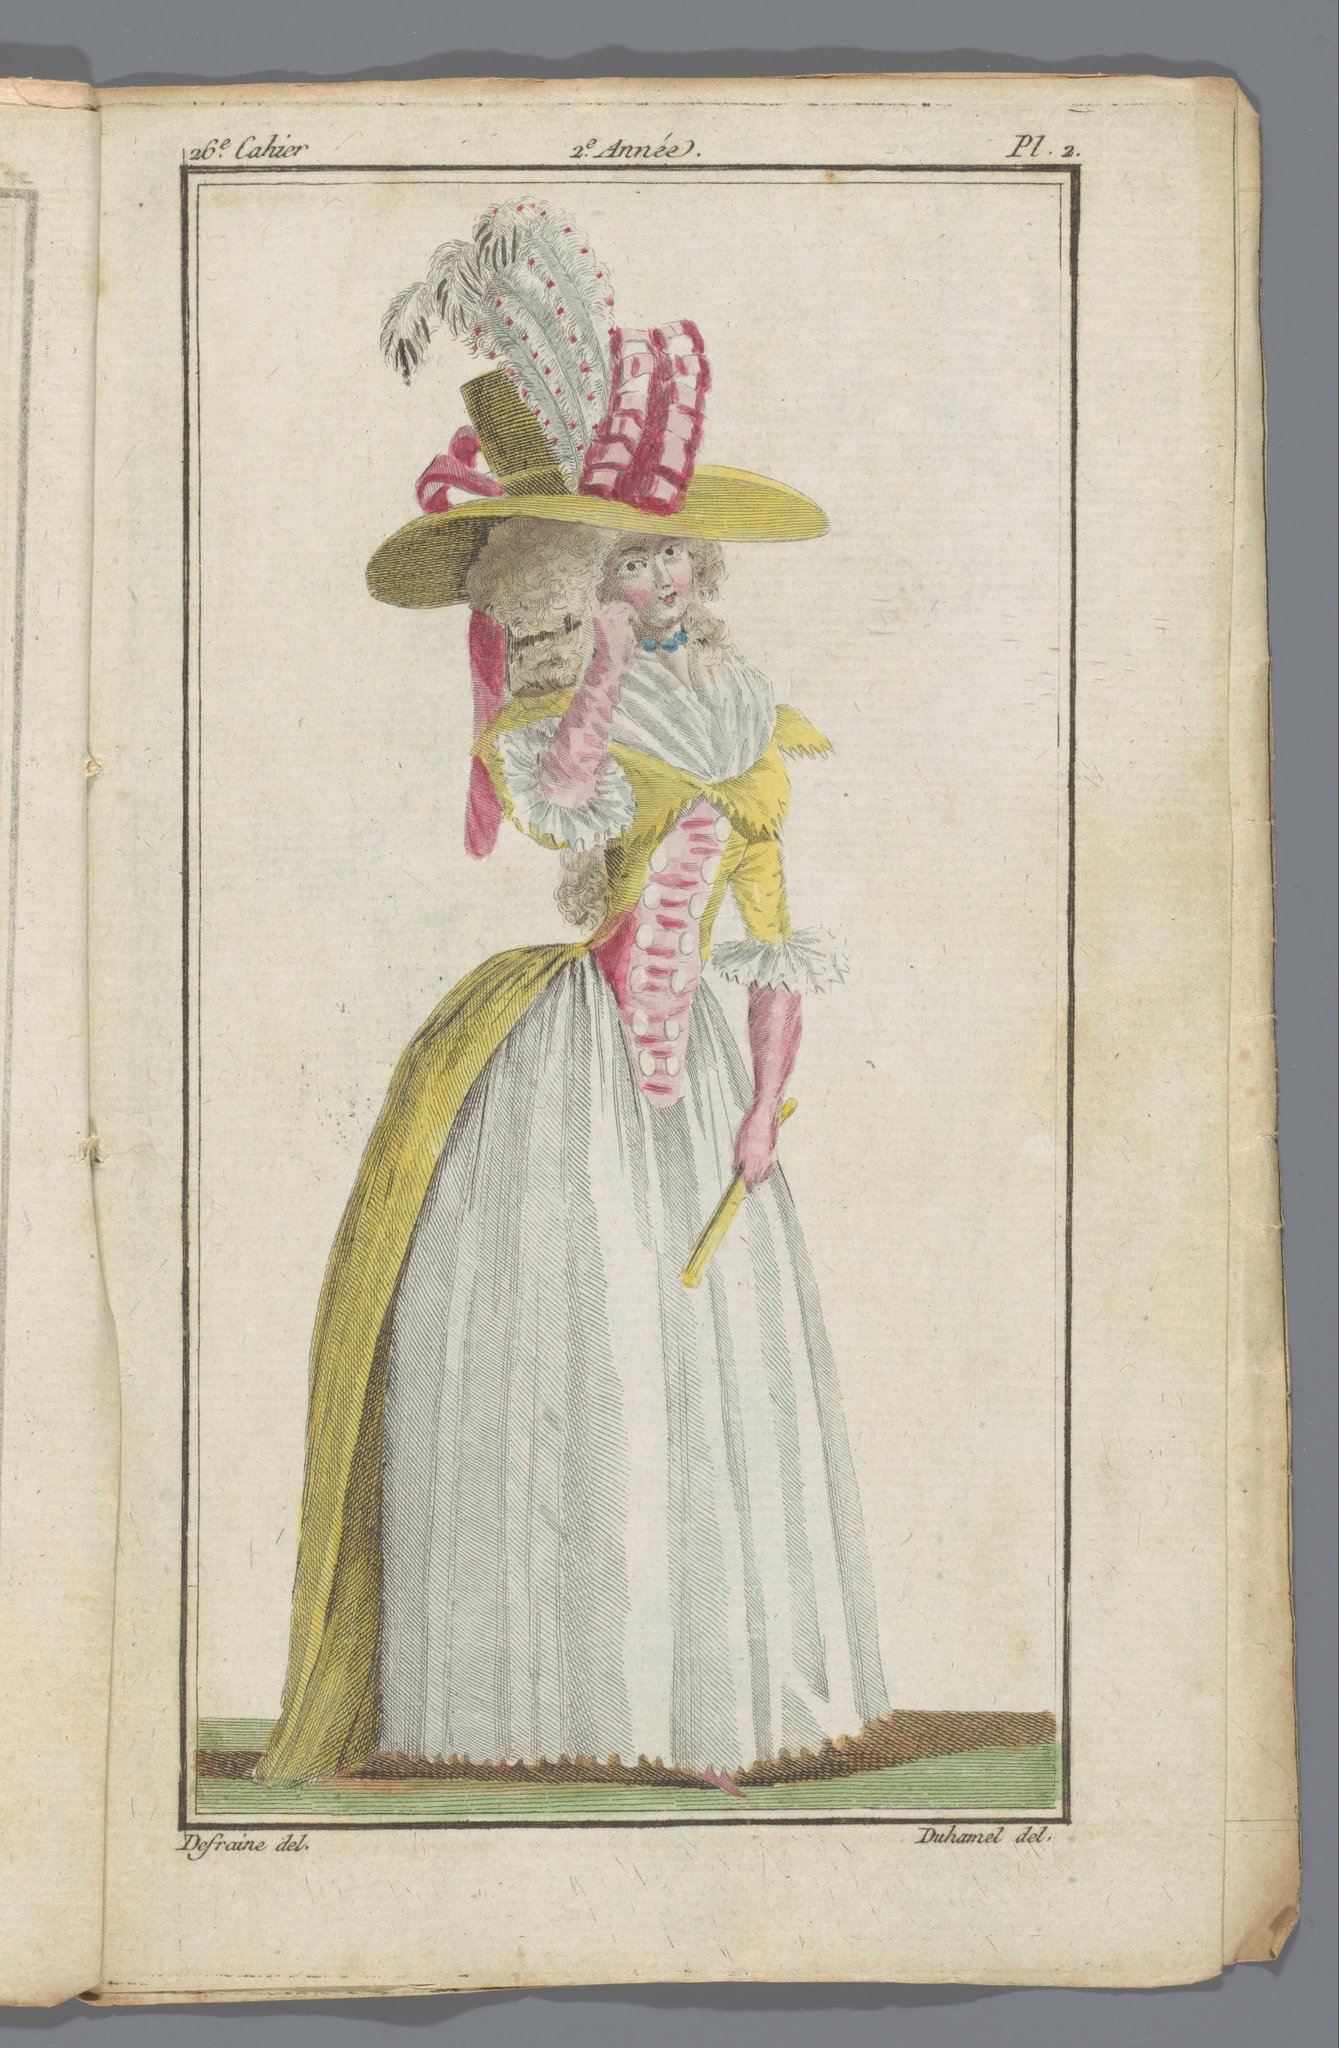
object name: fashion print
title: Magasin des Modes Nouvelles Françaises et Anglaises, 30 Juillet 1787, 26e cahier, 2e année, Pl. 2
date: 1787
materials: paper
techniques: engraving, hand coloring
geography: paris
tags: gloves, mittens (long gloves) (+ women's clothes), dress, gown: redingote (+ women's clothes), neck-gear: collar (+ women's clothes), fashion plates, head-gear: hat (+ women's clothes), fan (+ women's clothes), piece of clothing covering the breast or décolleté (fichu) (+ women's clothes), necklace (+ women's clothes)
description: Vrouw in een gele demi-redingote met grote kraag. Rok met geschulpte zoom. Om de hals een fichu. Accessoires: hoed versierd met veren en linten, collier, lange handschoenen, waaier. De prent maakt deel uit van het 26e Cahier uit de serie Magasin des Modes Nouvelles Françaises et Anglaises. De serie bestaat uit 172 modeprenten, uitgegeven door Buisson, Parijs, 20 november 1786 - 21 décembre 1789